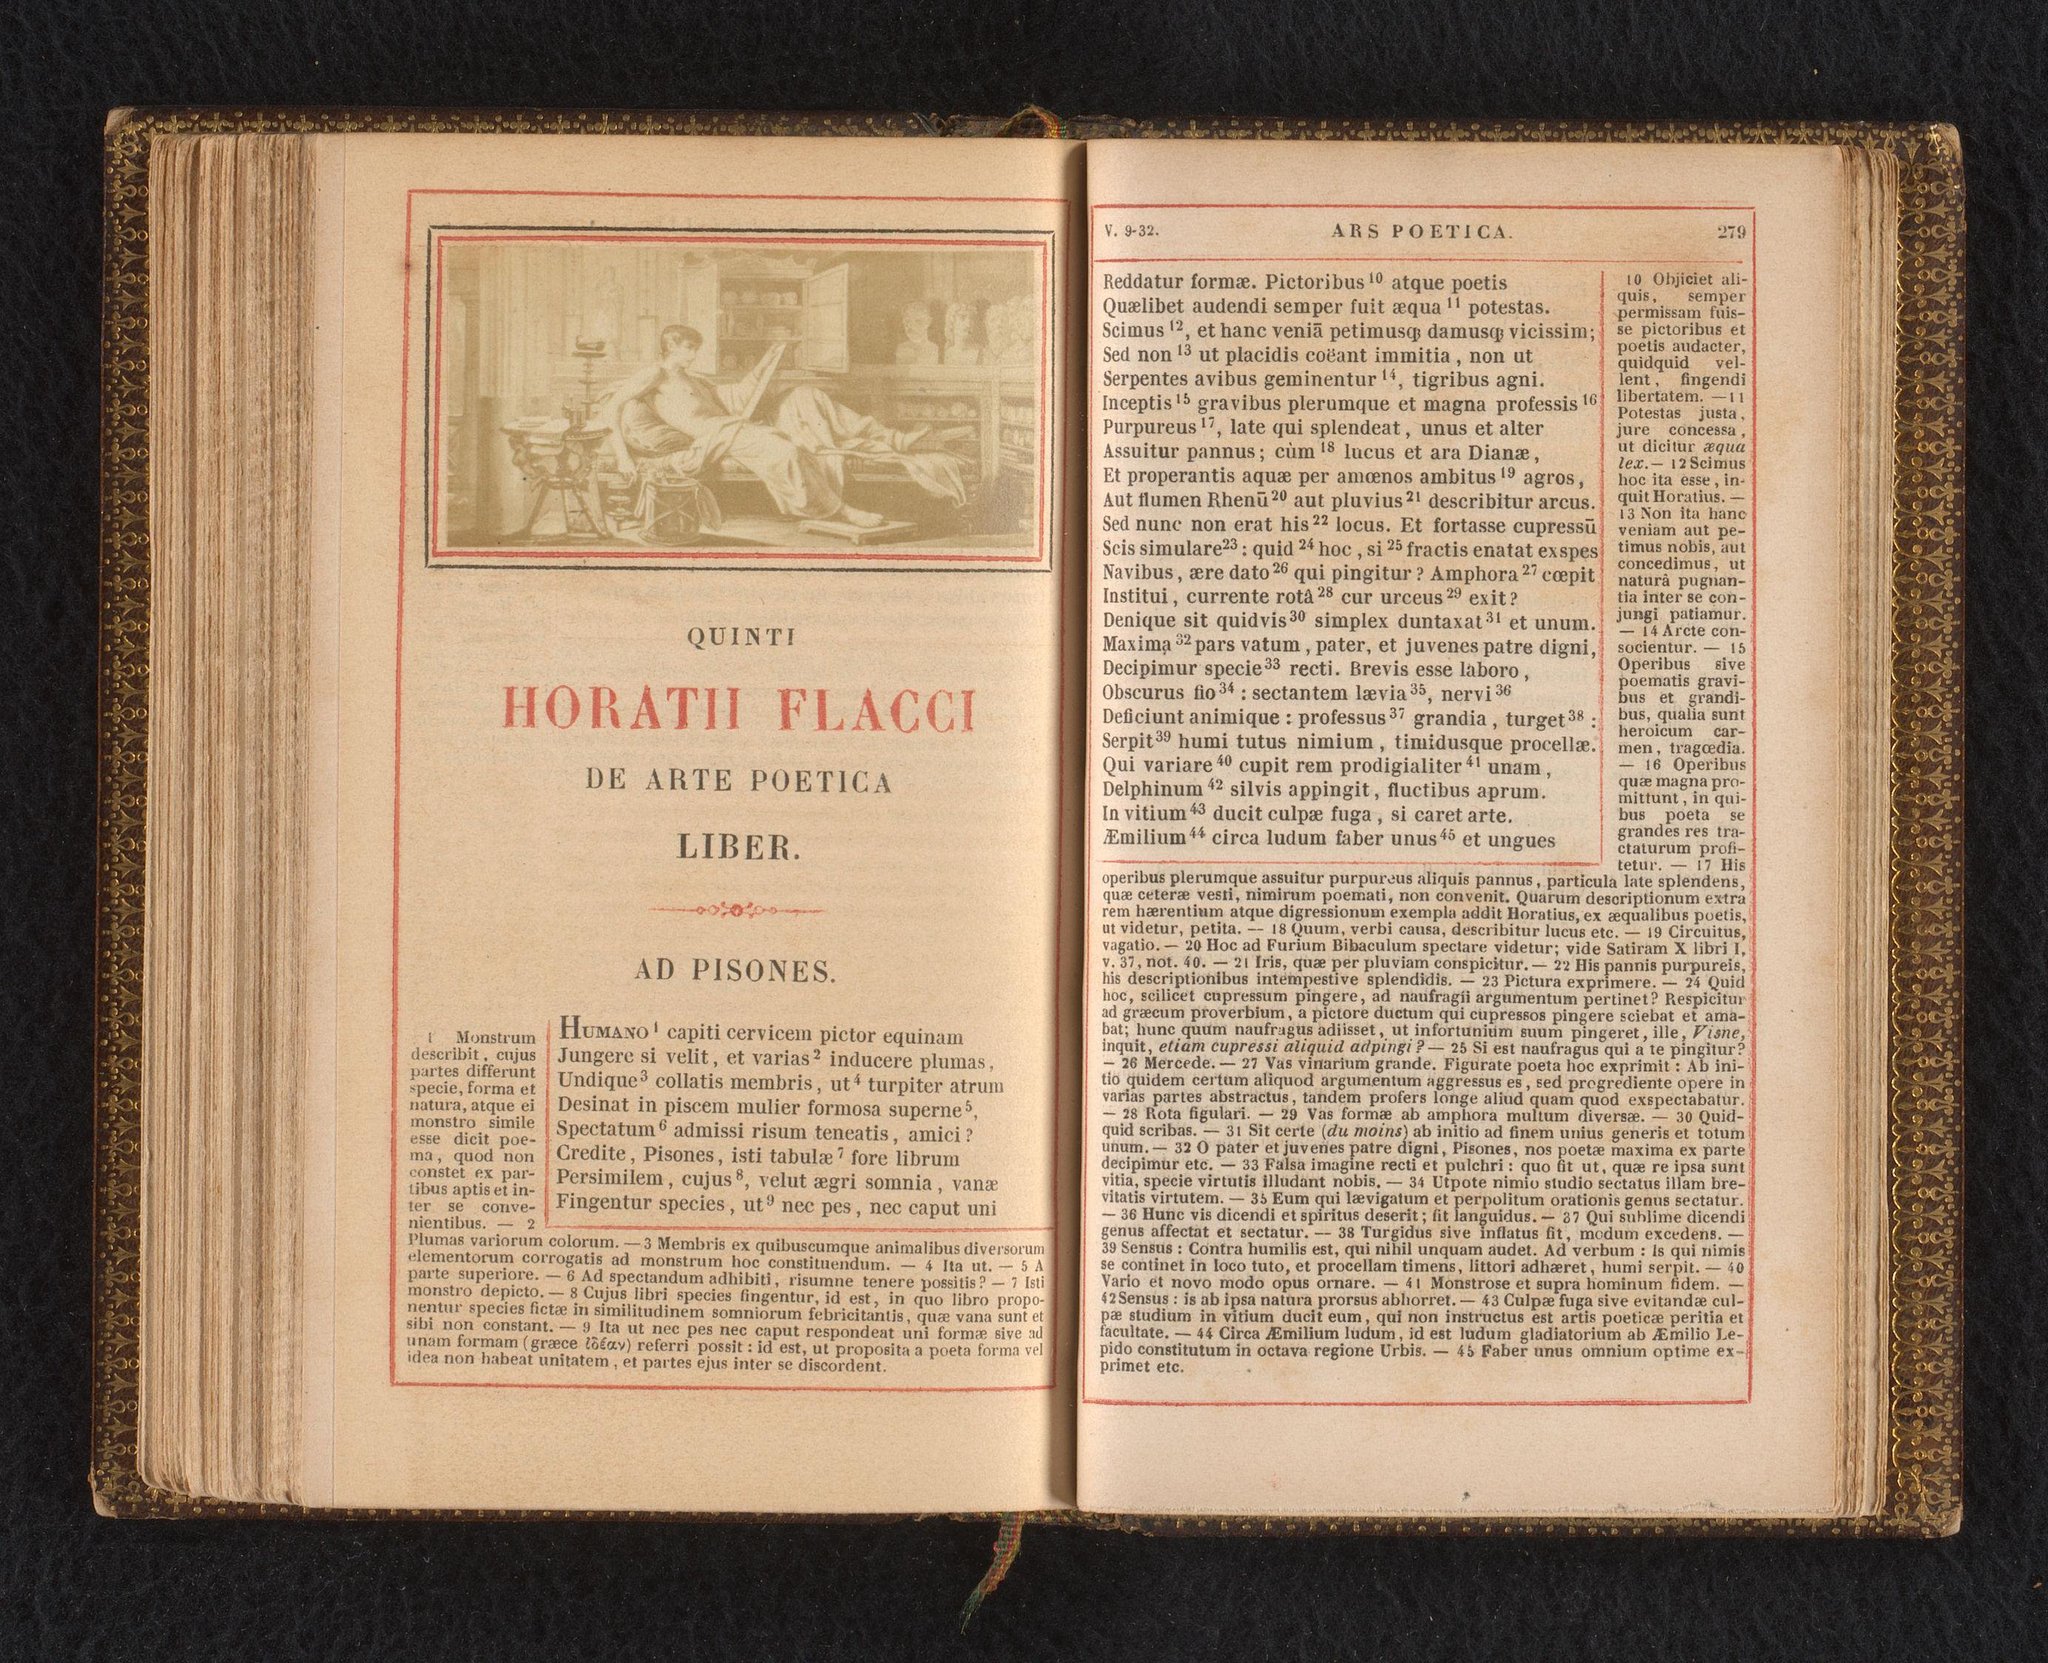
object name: photograph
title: Fotoreproductie van een illustratie van een lezende man op een ligbed in een Romeins interieur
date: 1851-1855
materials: paper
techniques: albumen print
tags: reading, couch, sofa, settee